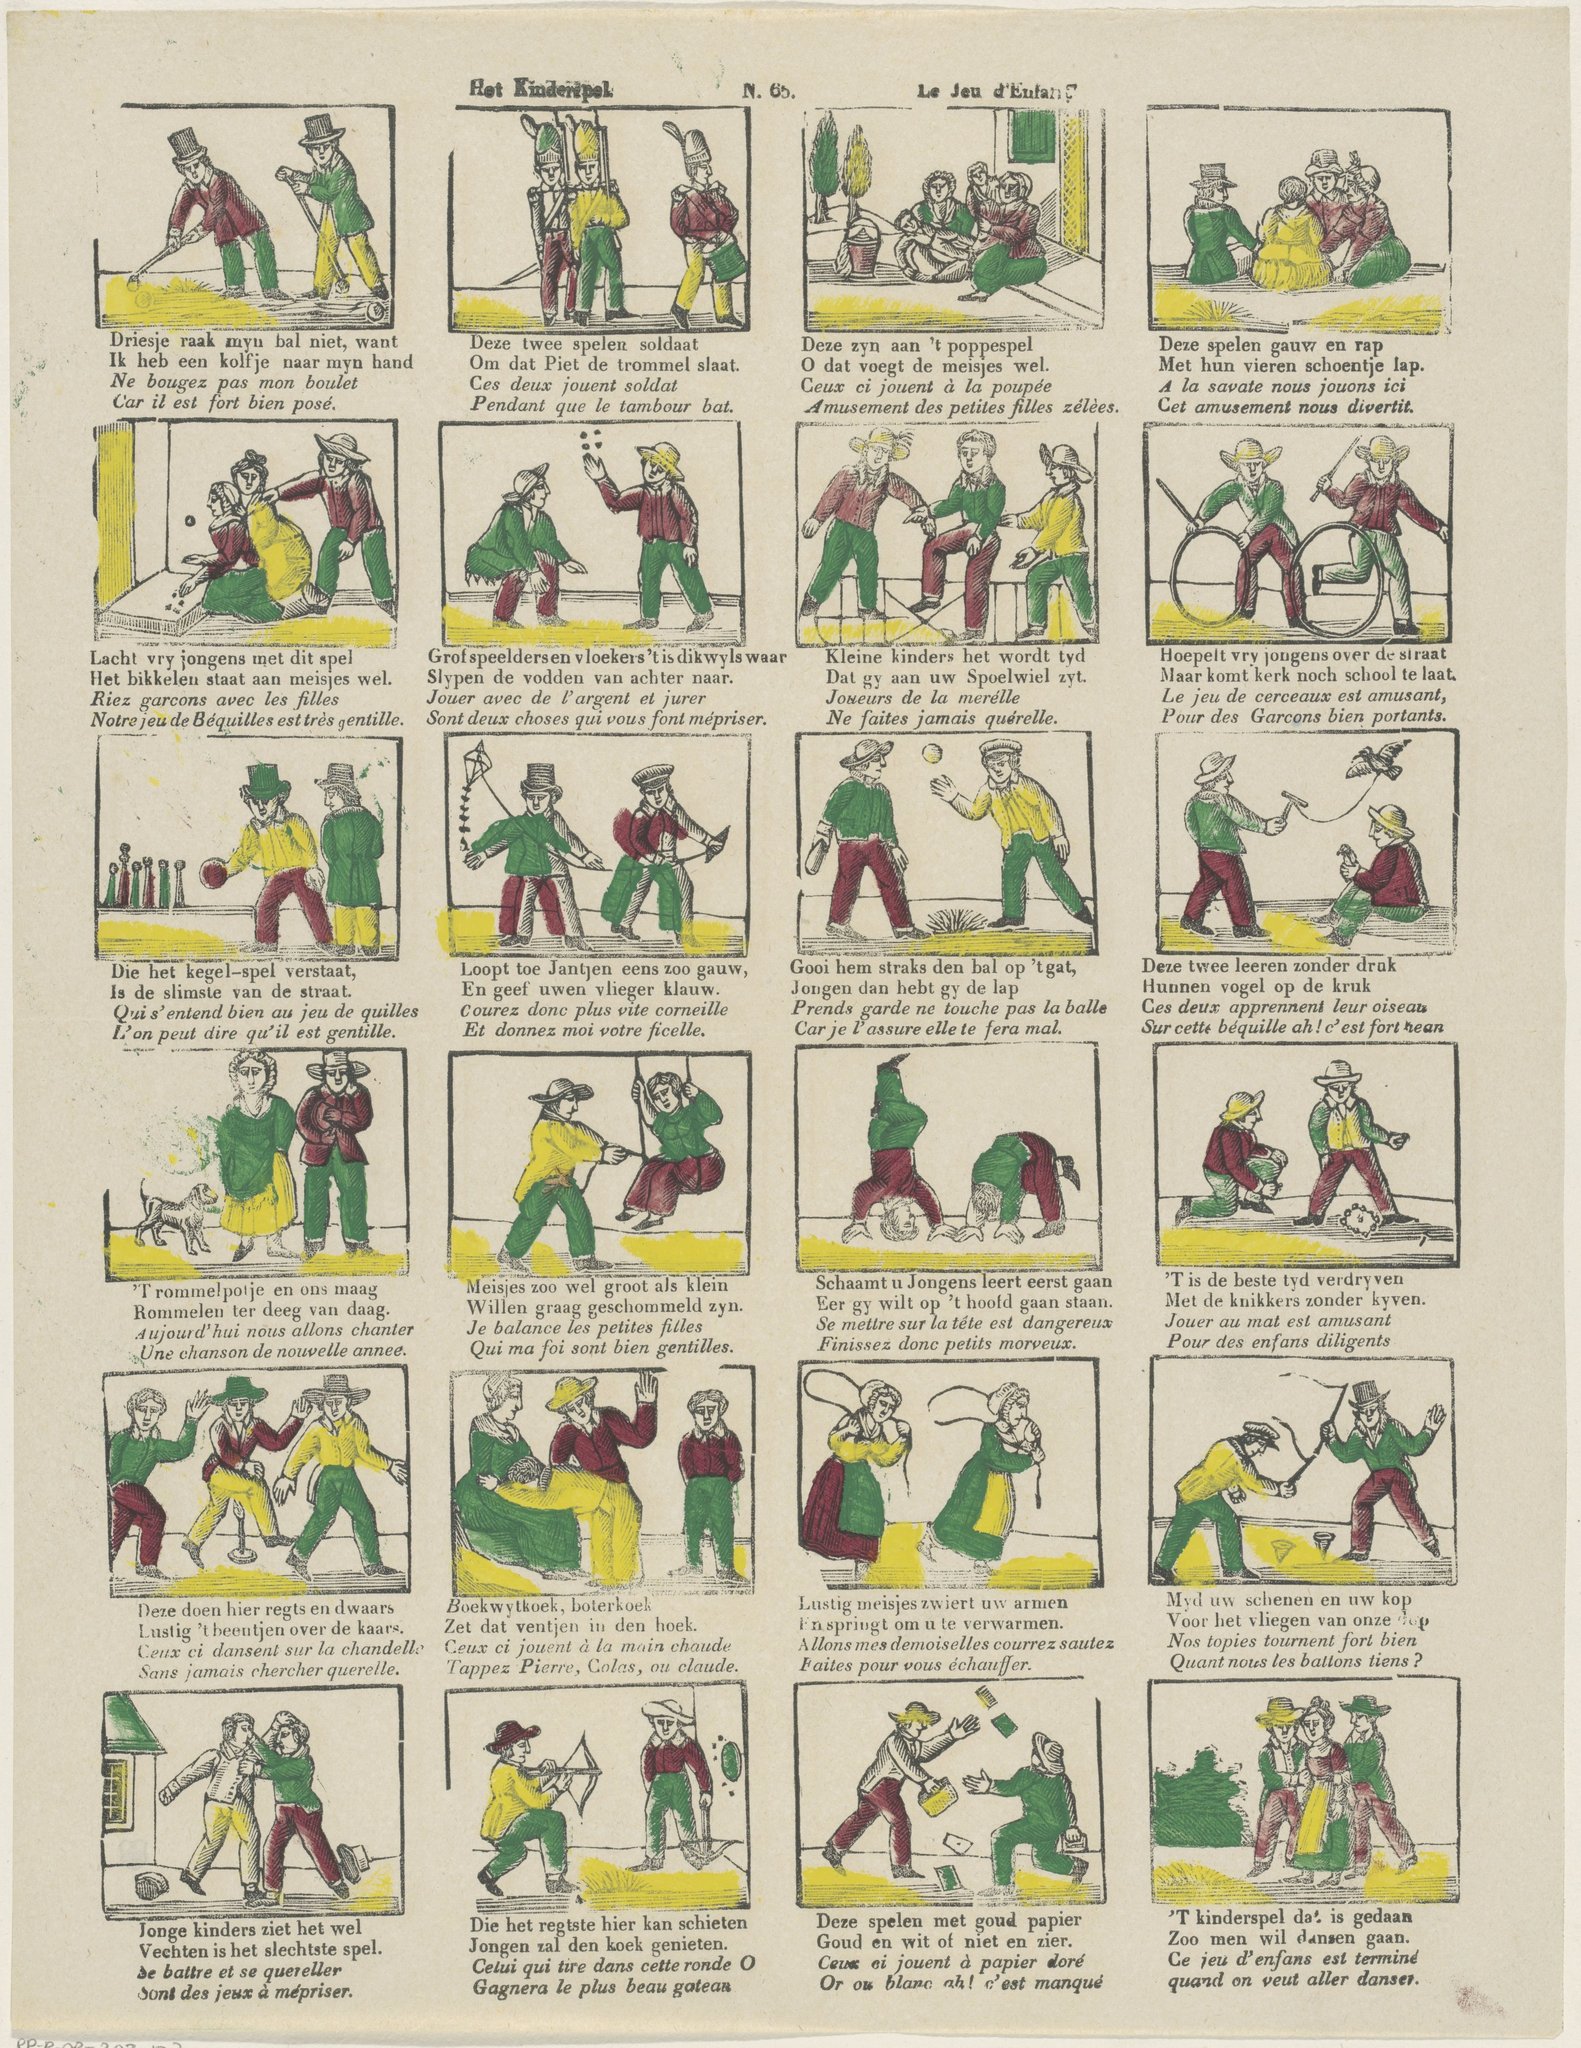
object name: print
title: Het kinderspel / Le jeu d'Enfant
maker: Anonymous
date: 1833-1900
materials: paper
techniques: colour, letterpress printing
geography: netherlands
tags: children's games and plays, (playing with) dolls, games using special objects (marbles, top, hoop, etc.), jumping-rope games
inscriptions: collector's mark: Lugt 2760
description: Blad met 24 voorstellingen van kinderspelen, waaronder soldaatje spelen, hoepelen, vliegeren, schommelen en touwtjespringen. Onder elke afbeelding een tweeregelig vers in het Nederlands en in het Frans. Genummerd midden boven: N. 65.